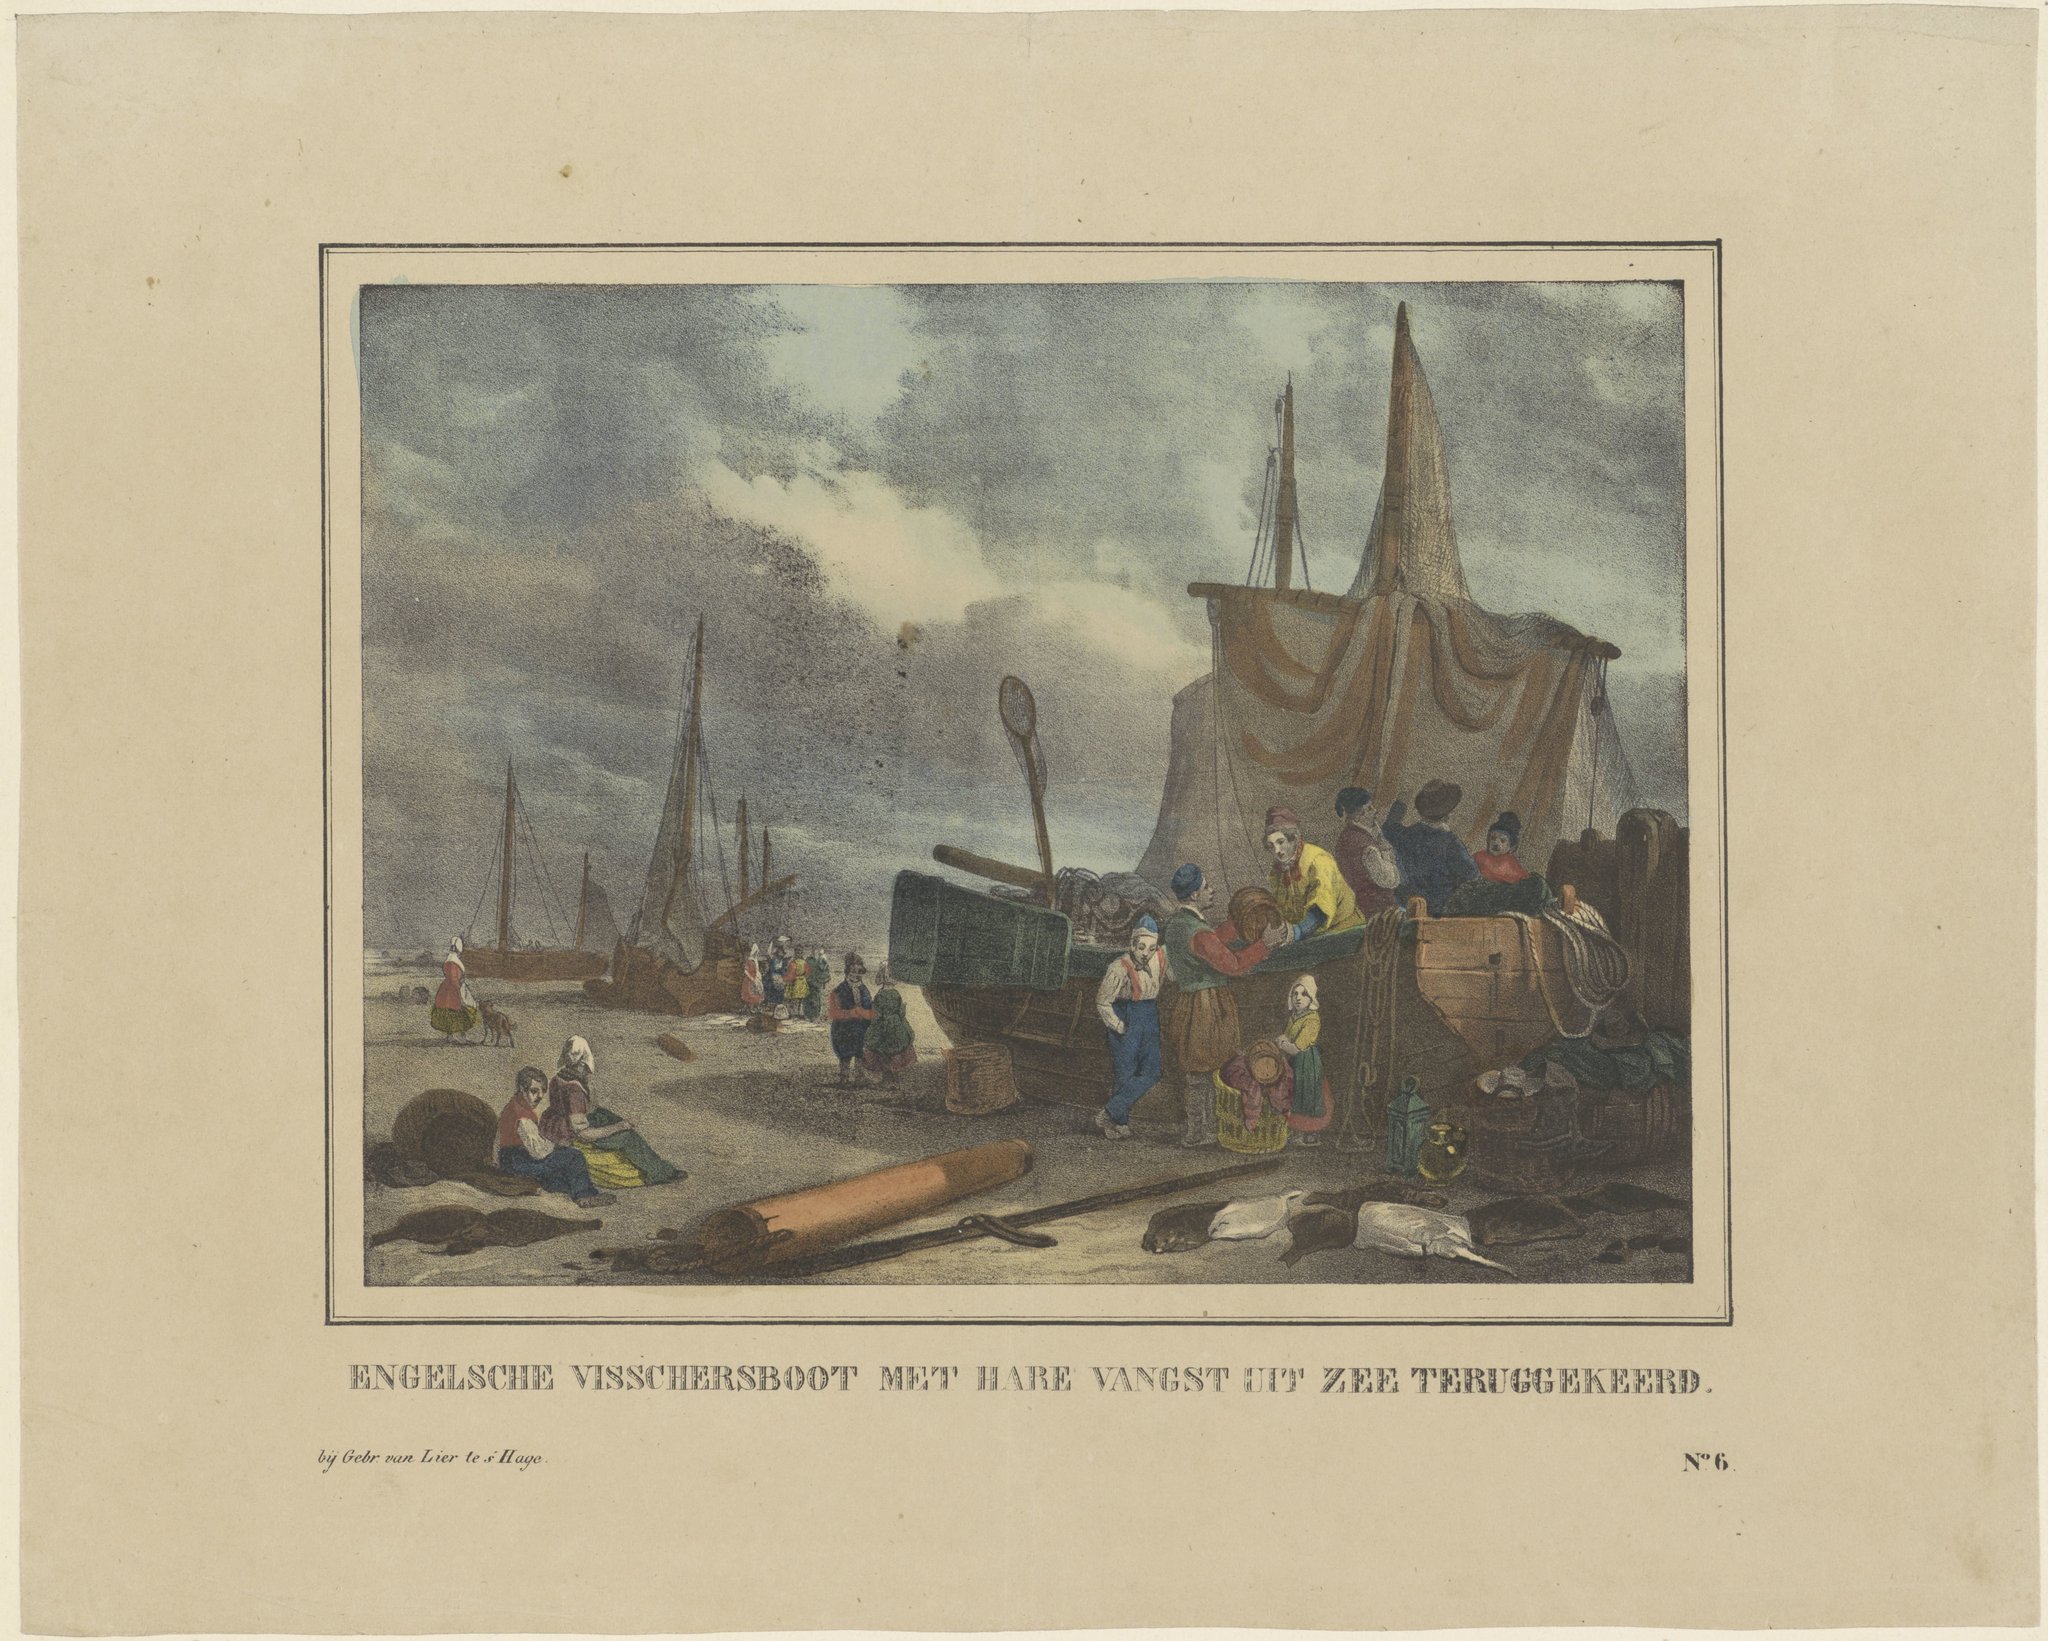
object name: print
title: Engelsche visschersboot met hare vangst uit zee teruggekeerd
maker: Anonymous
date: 1840-1850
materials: paper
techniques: lithograph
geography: netherlands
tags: ships (in general) - cc - more than one ship, fisherman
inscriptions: collector's mark: Lugt 2760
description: Drie vissersboten op de kust. De boot het meest in de voorgrond wordt nog uitgeruimd. Genummerd rechtsonder: No. 6.